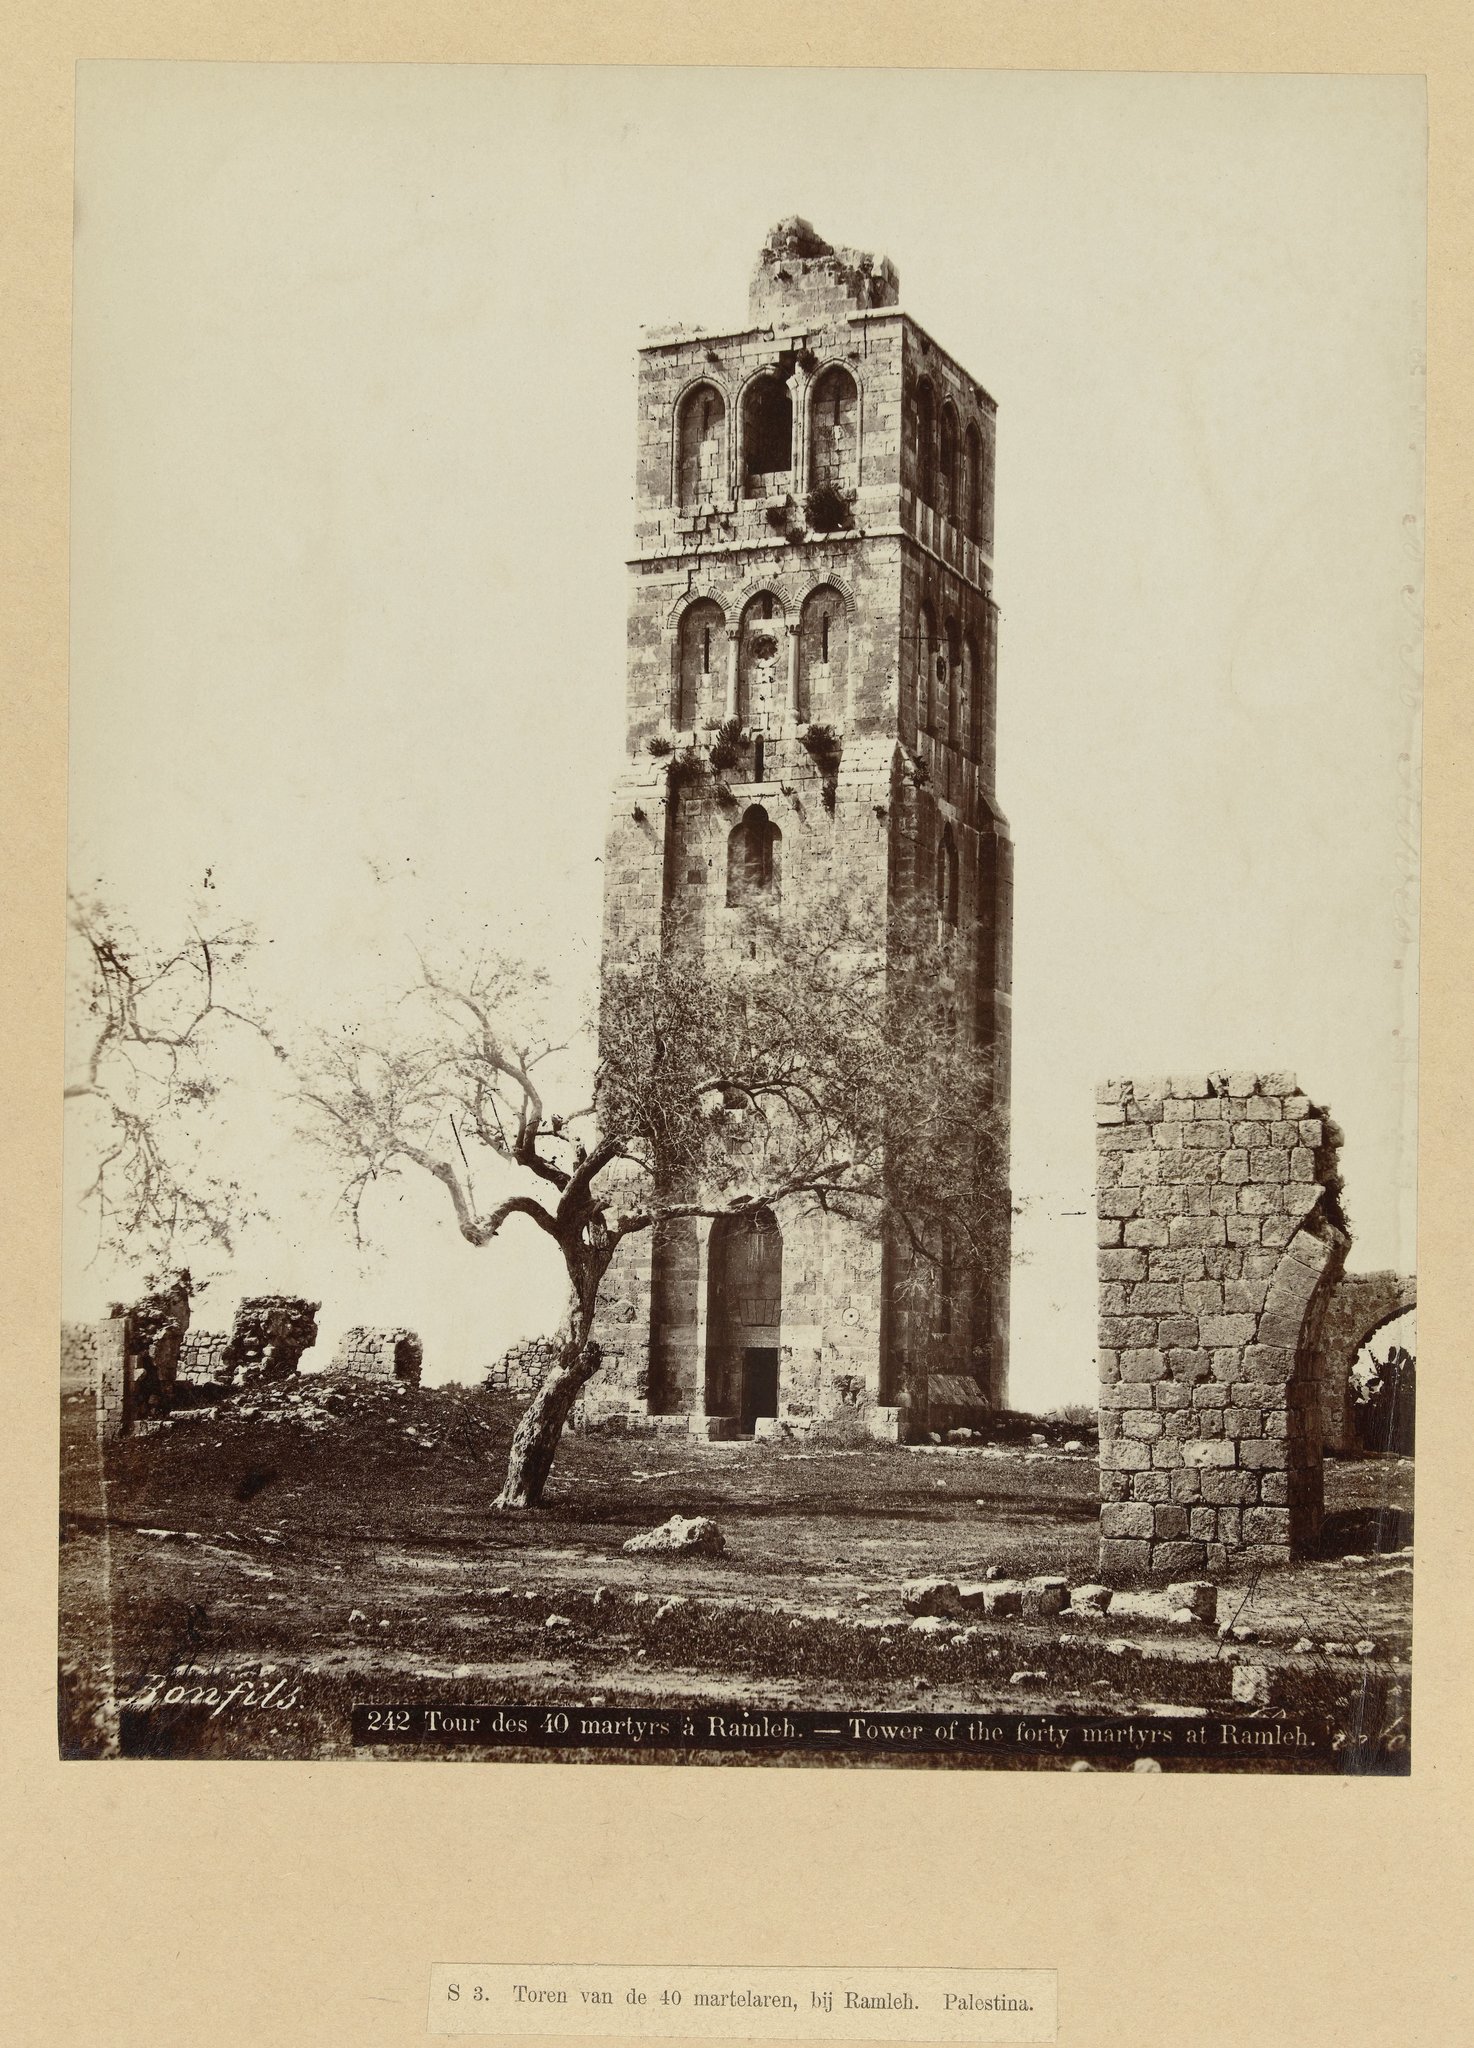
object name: photograph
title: Tour des 40 martyrs à Ramleh.-Tower of the forty martyrs at Ramleh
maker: félix bonfils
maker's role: fotograaf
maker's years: 1831-1885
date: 1867-1877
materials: cardboard, paper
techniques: albumen print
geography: ramla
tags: tower, clock tower ~ monumental adornment, temple, shrine ~ islam, mohammedanism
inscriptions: number: ‘242’, stamp: ‘Gemeentelijke bibliotheek/ Rotterdam’, title: ‘S 3. Toren van de 40 martelaren, bij Ramleh. Palestina.’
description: Onderdeel van een groep door fotograaf Richard Polak op reis verzamelde foto’s. Deze foto is samen met andere op zijn reizen verzamelde foto's tentoongesteld bij de Rotterdamsche Kunstkring (1895), Arti en Amicitiae te Amsterdam (1897-1898?) en Societeit 't Collegie te Kampen (datum vooralsnog onbekend).